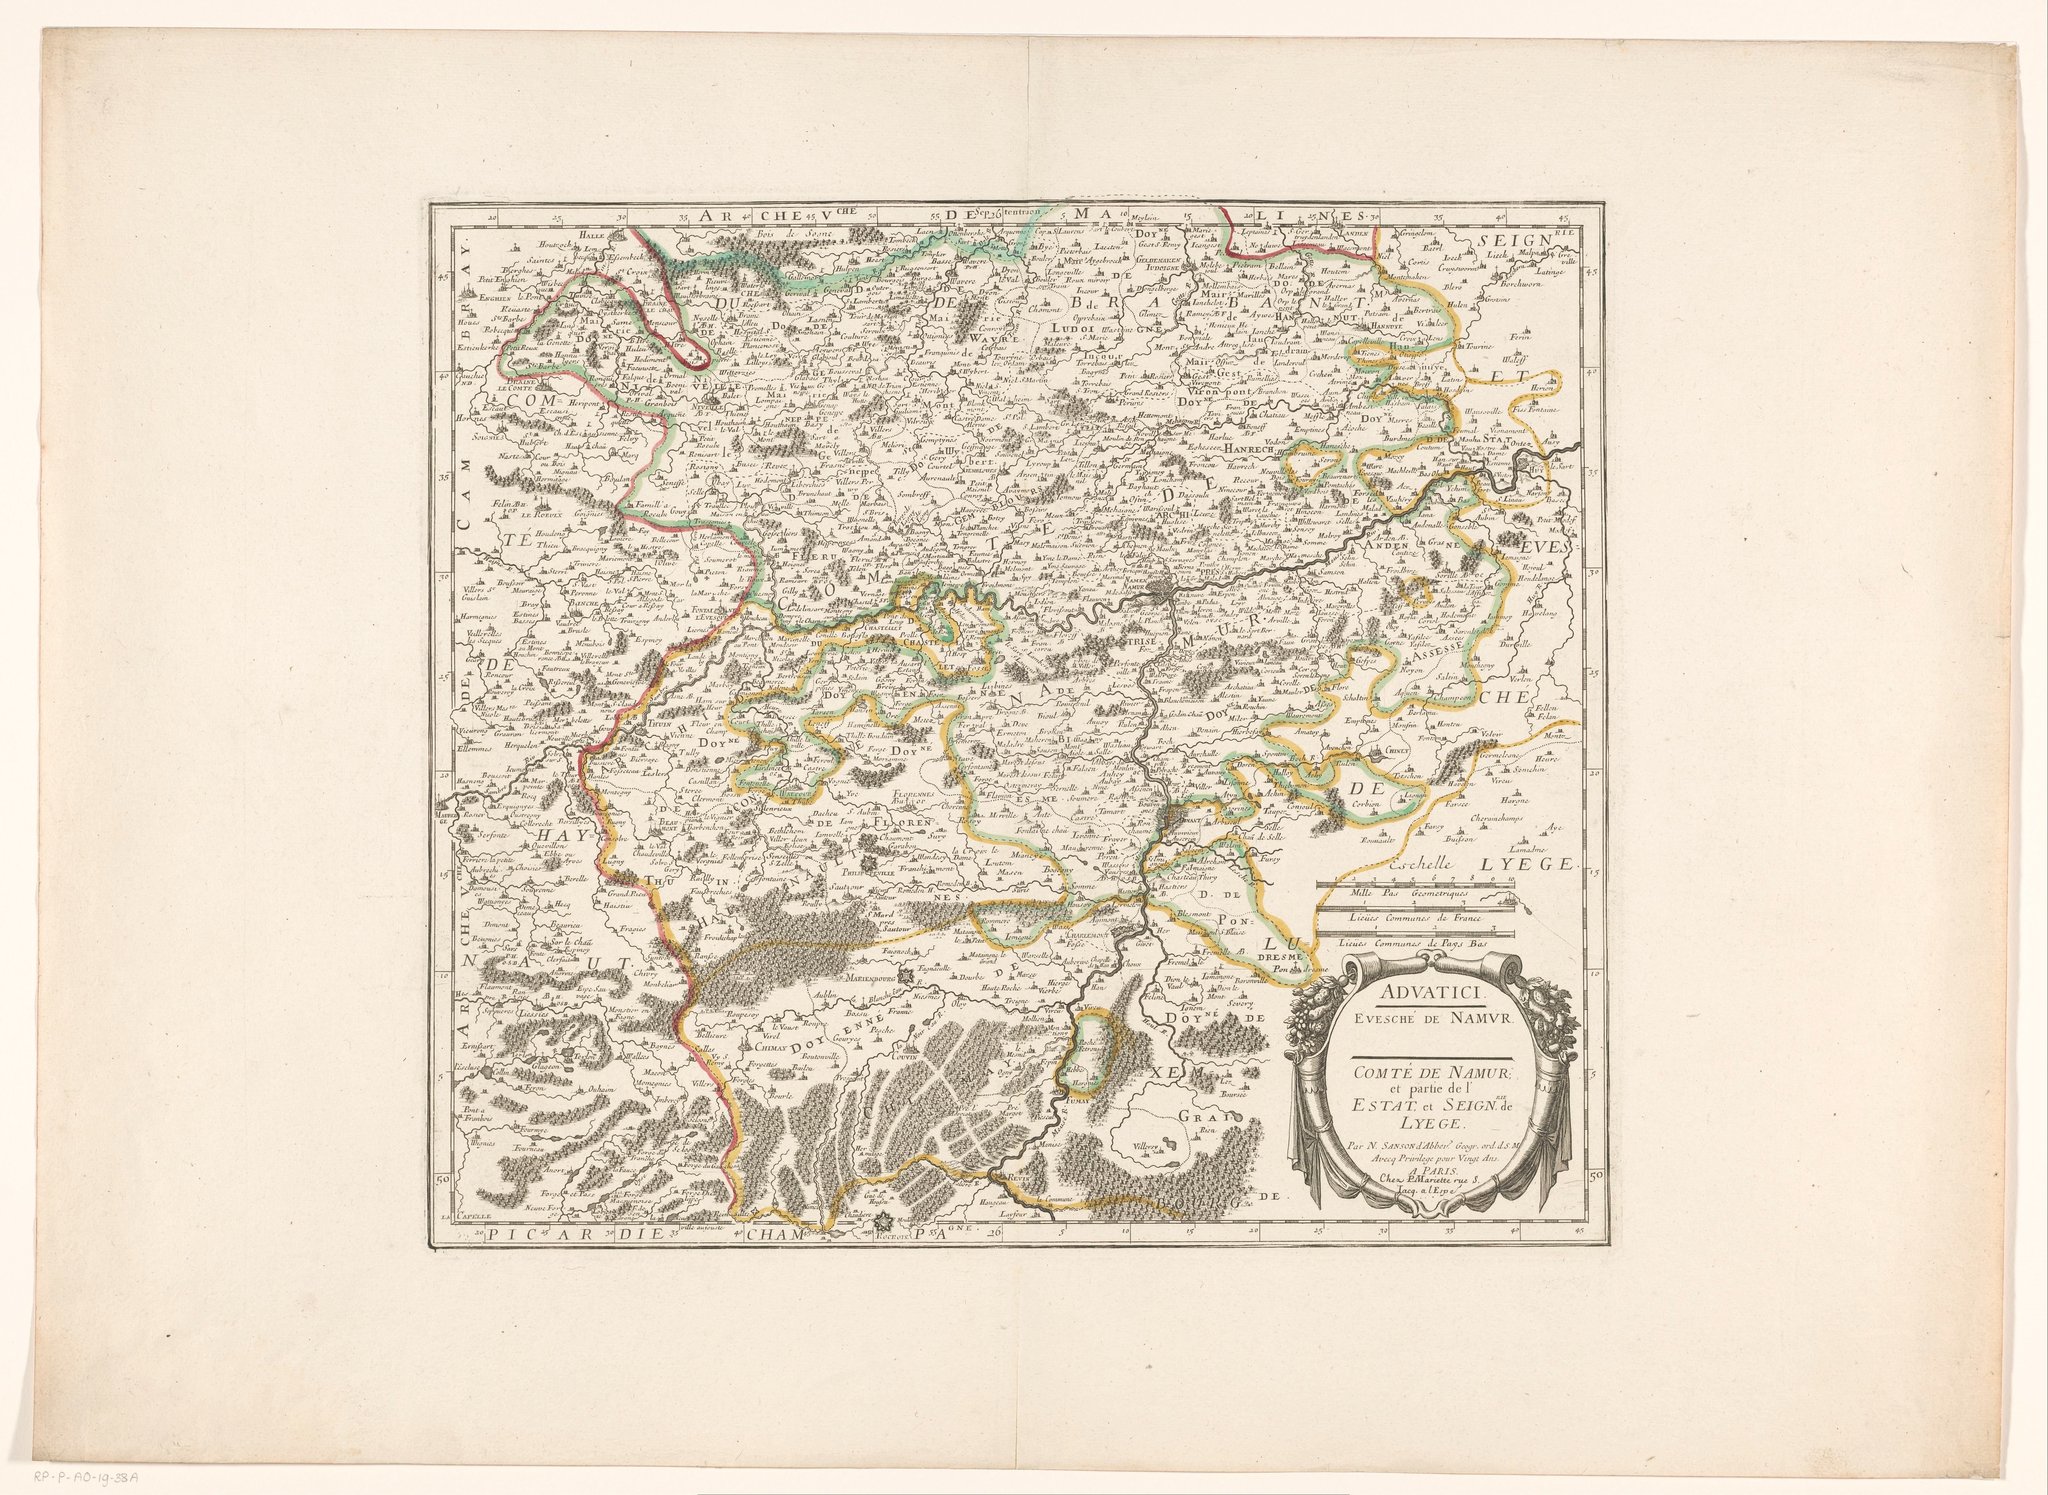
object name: print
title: Kaart van het graafschap Namen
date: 1647-1667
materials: paper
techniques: engraving, etching, hand coloring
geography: paris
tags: maps of separate countries or regions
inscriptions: collector's mark: Lugt 2228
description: Kaart van het graafschap Namen. Rechtsonder de titelcartouche. Daarboven drie schaalstokken: 10 Mille Pas Geometriques / 4 Lieües Communes de France / 3 Lieües Communes de Pays Bas. De kaart is voorzien van een gradenverdeling langs de randen.